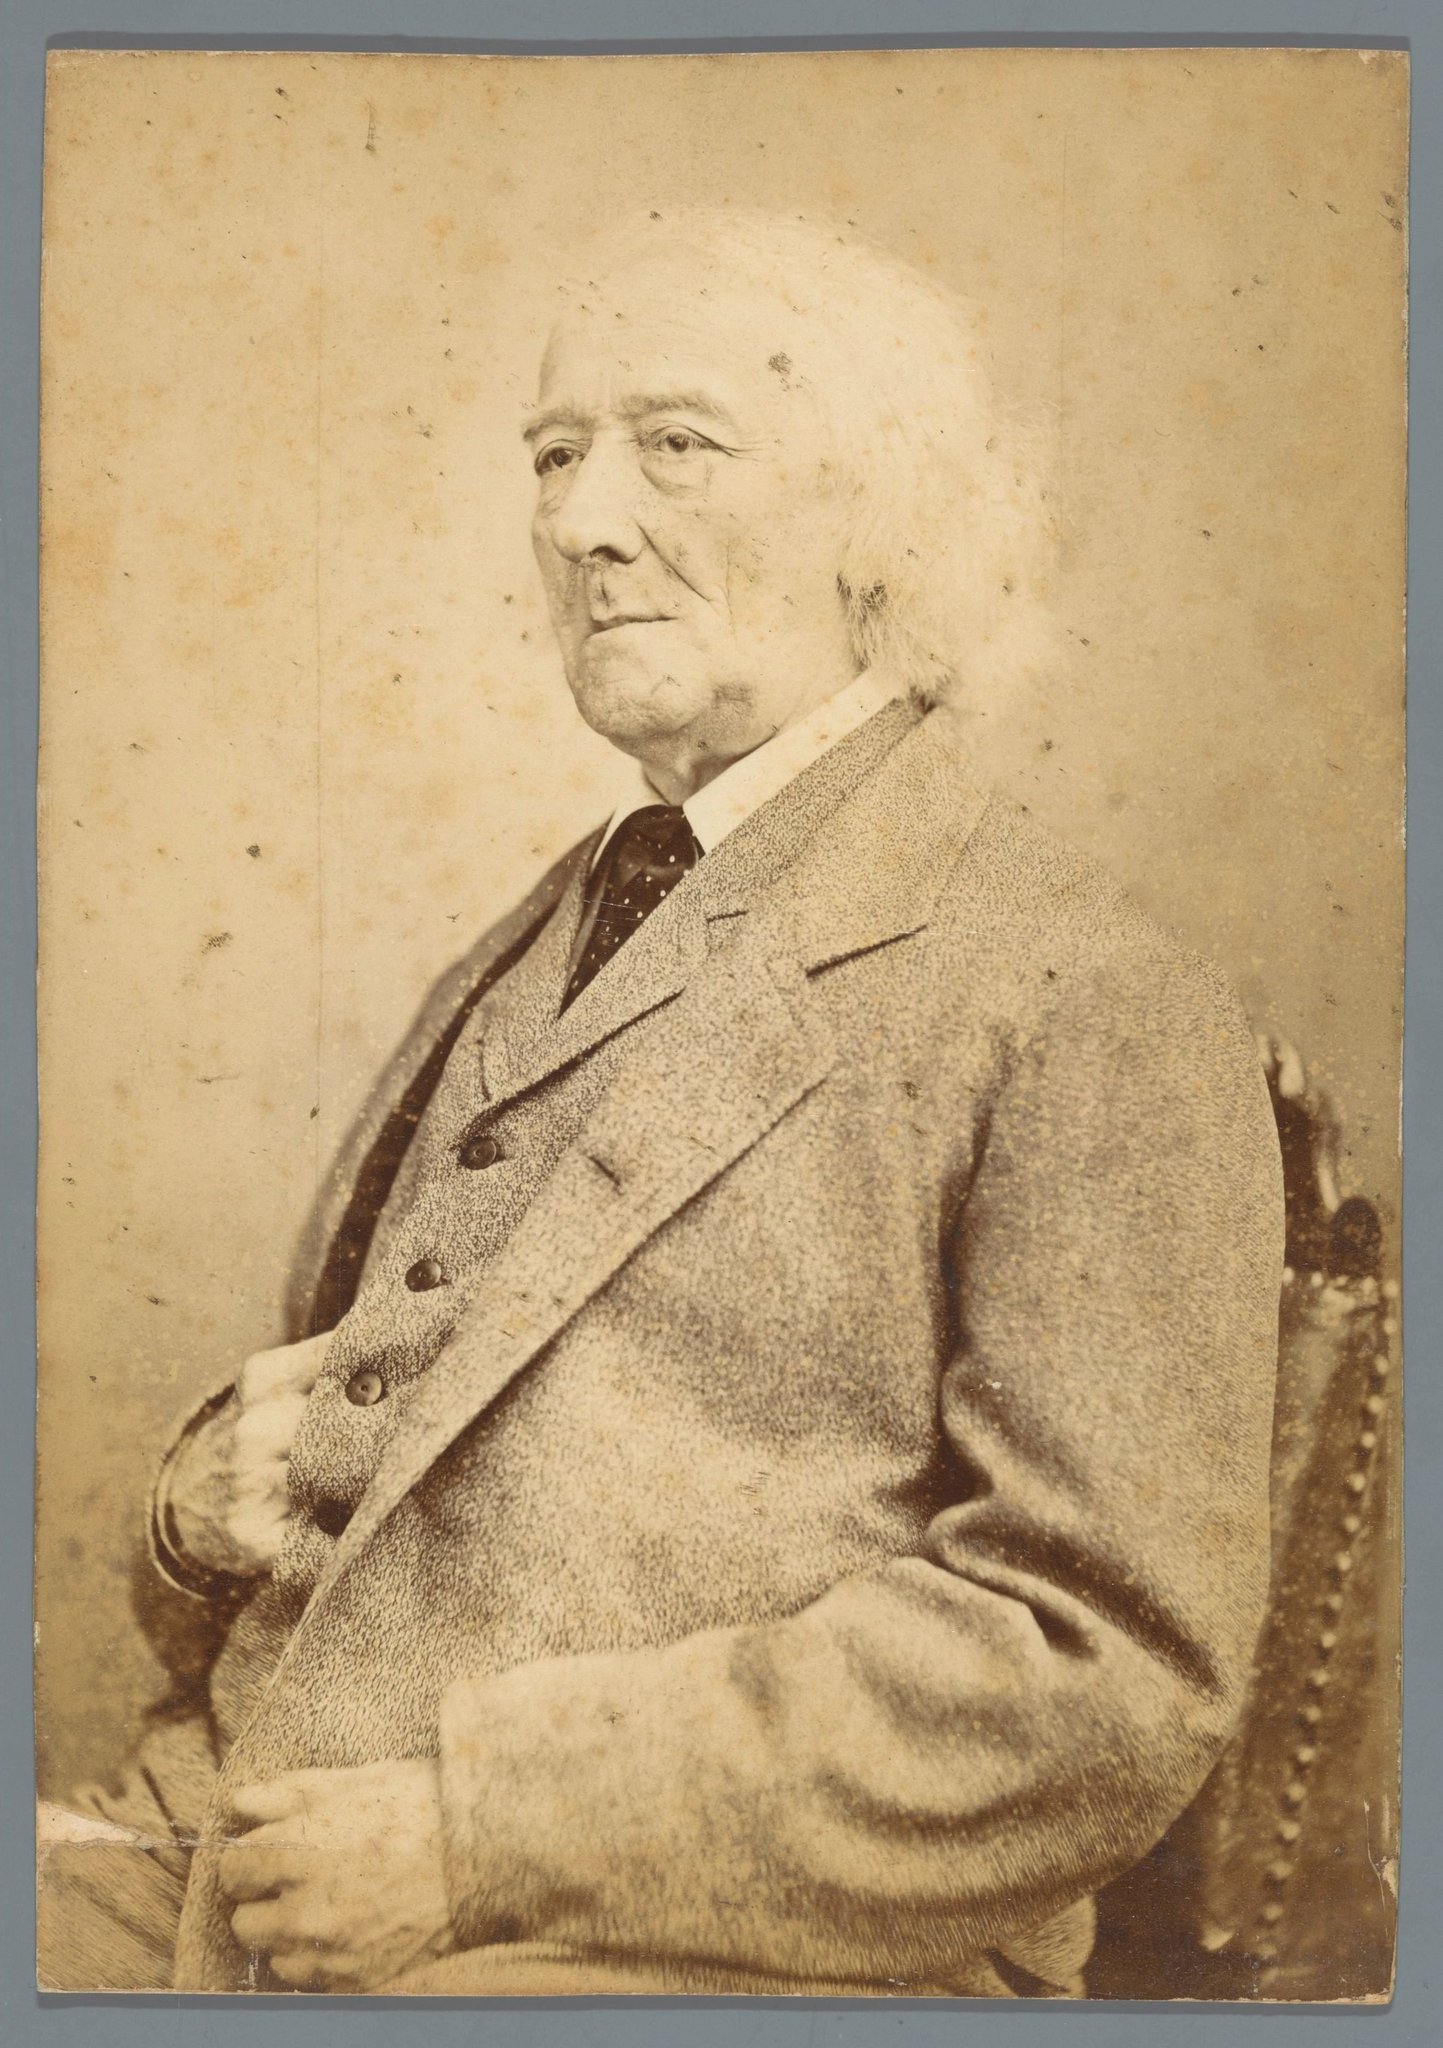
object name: cabinet photograph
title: Portret van Jacob van Lennep (1802-1868)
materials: cardboard, photographic support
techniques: albumen print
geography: amsterdam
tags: adult man